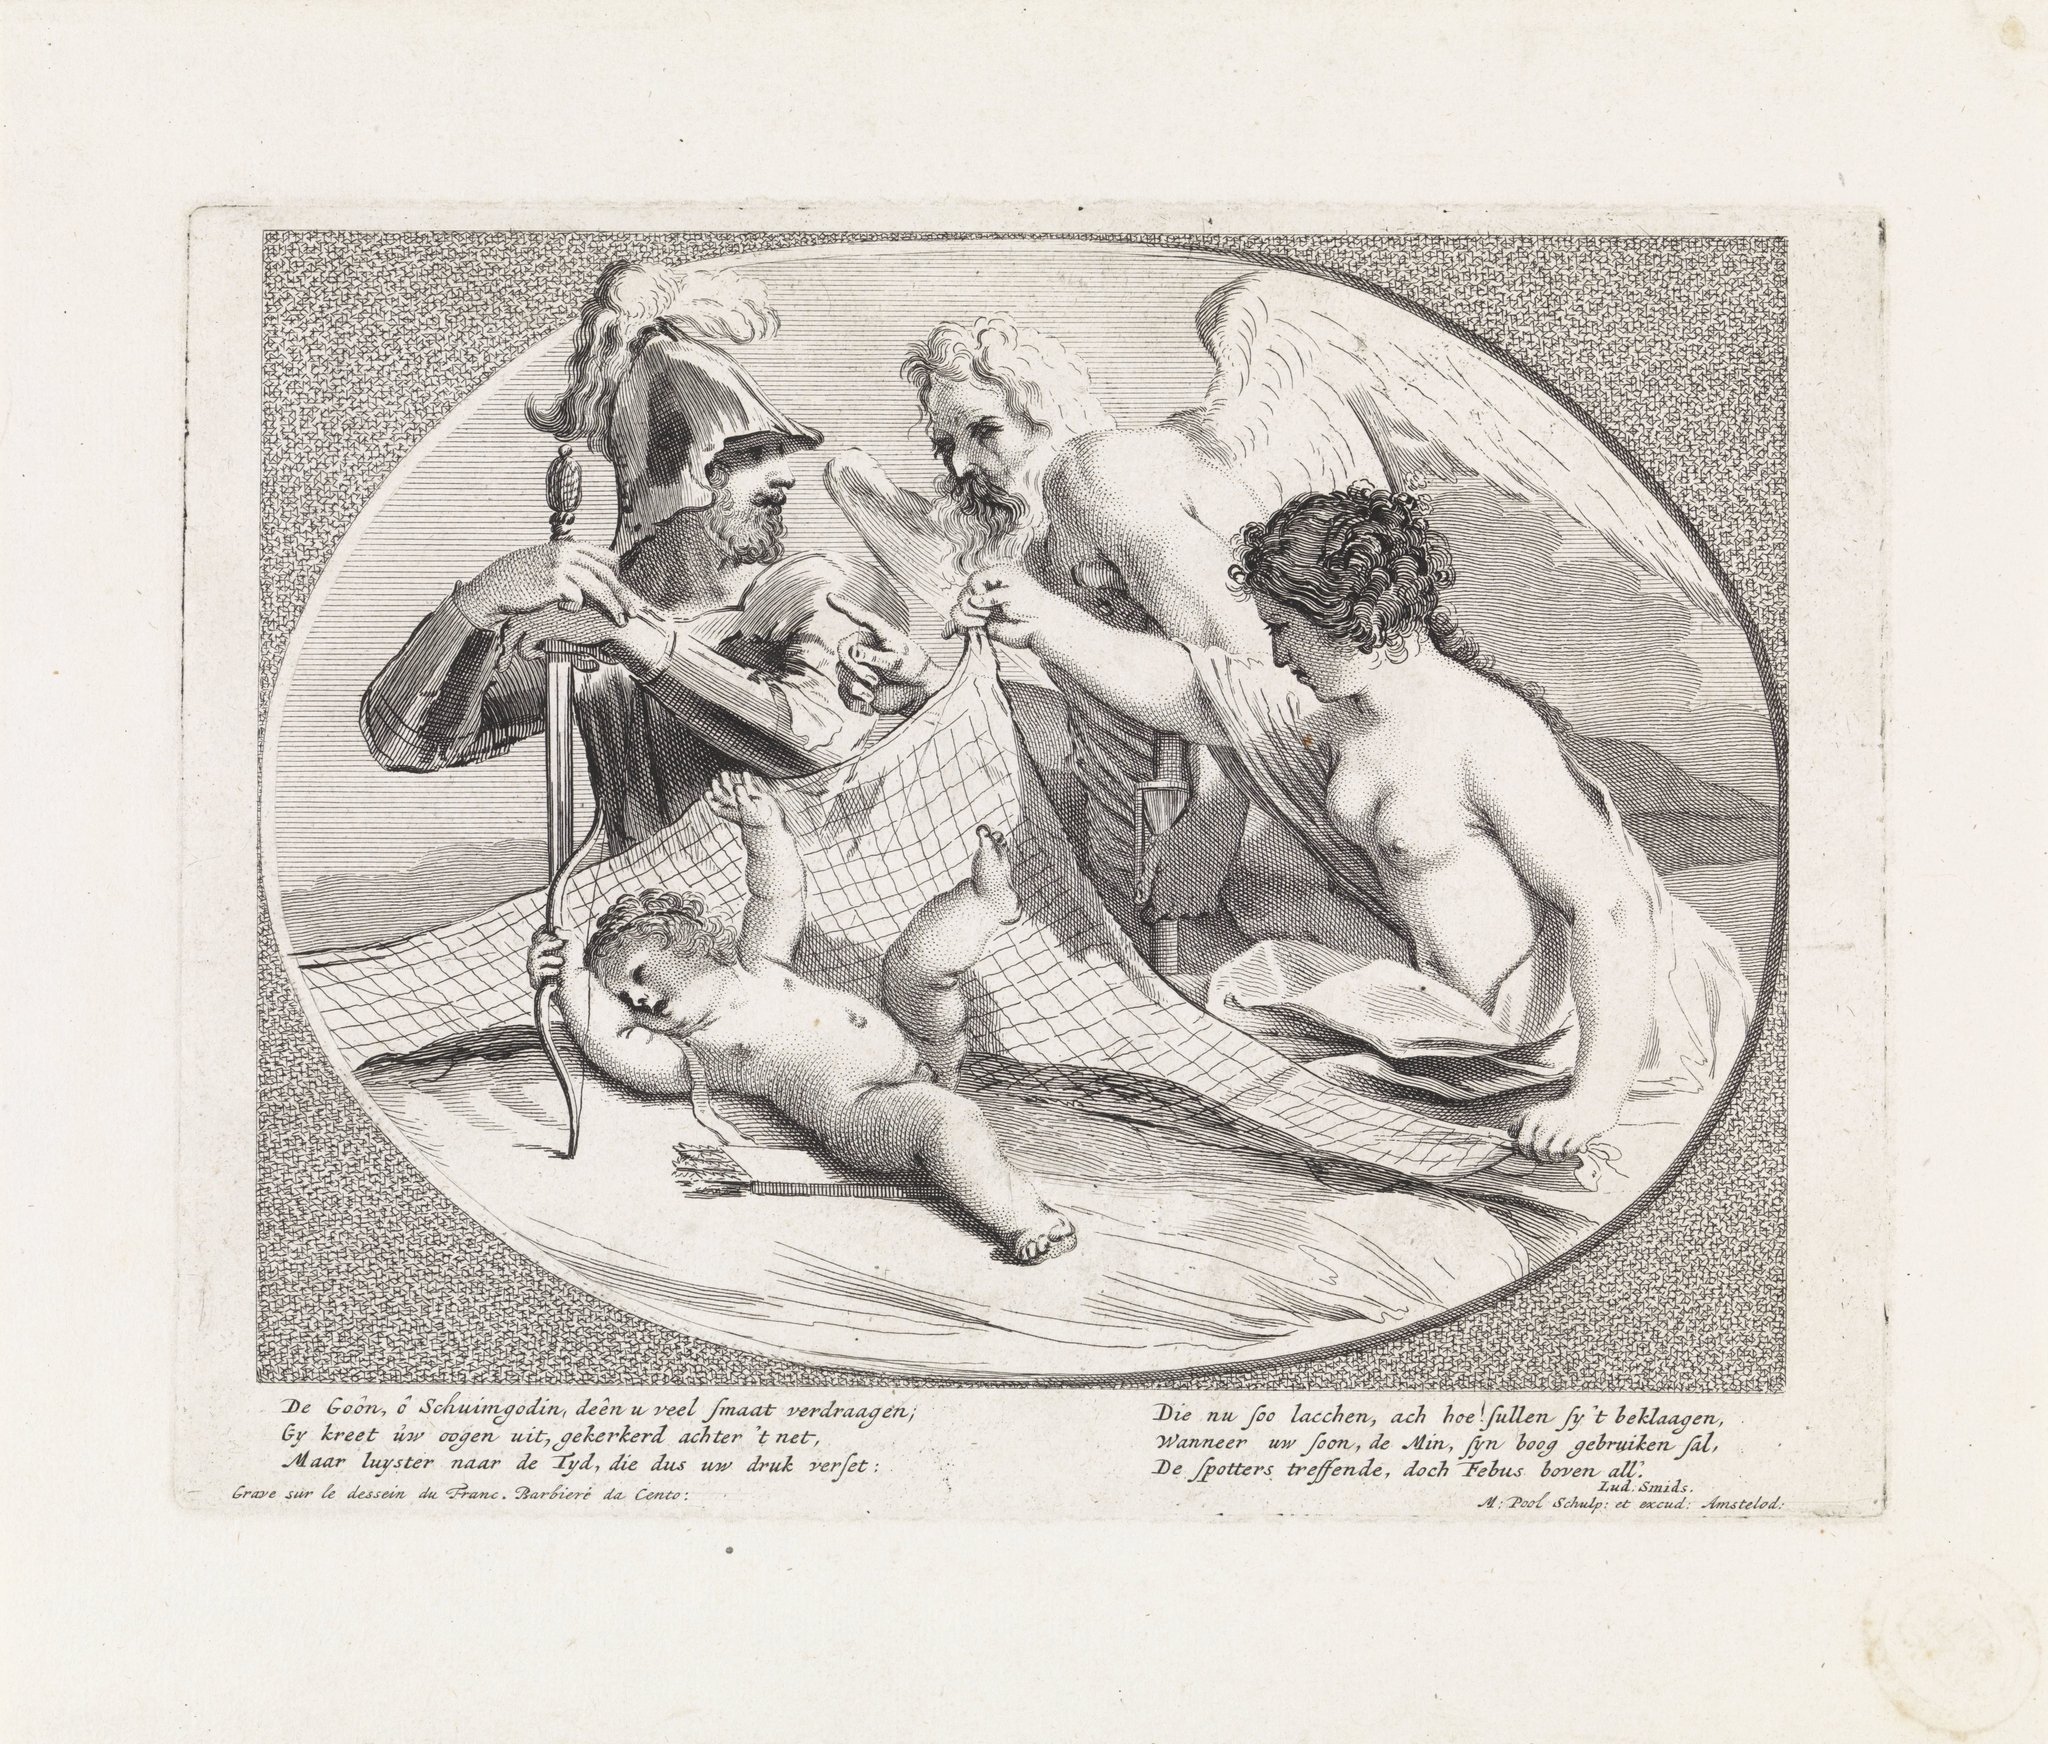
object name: print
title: Amor in een net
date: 1696-1727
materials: paper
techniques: engraving, etching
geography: amsterdam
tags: (story of) mars (ares), (story of) cupid, amor (eros), (story of) venus (aphrodite), father time, man with wings and scythe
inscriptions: collector's mark: Lugt 240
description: Venus houdt Amor omhoog in een net. De jonge Amor speelt met zijn boog. Vader Tijd spreekt Mars vermanend toe. In de marge een zesregelig gedicht, in twee kolommen, in het Nederlands.